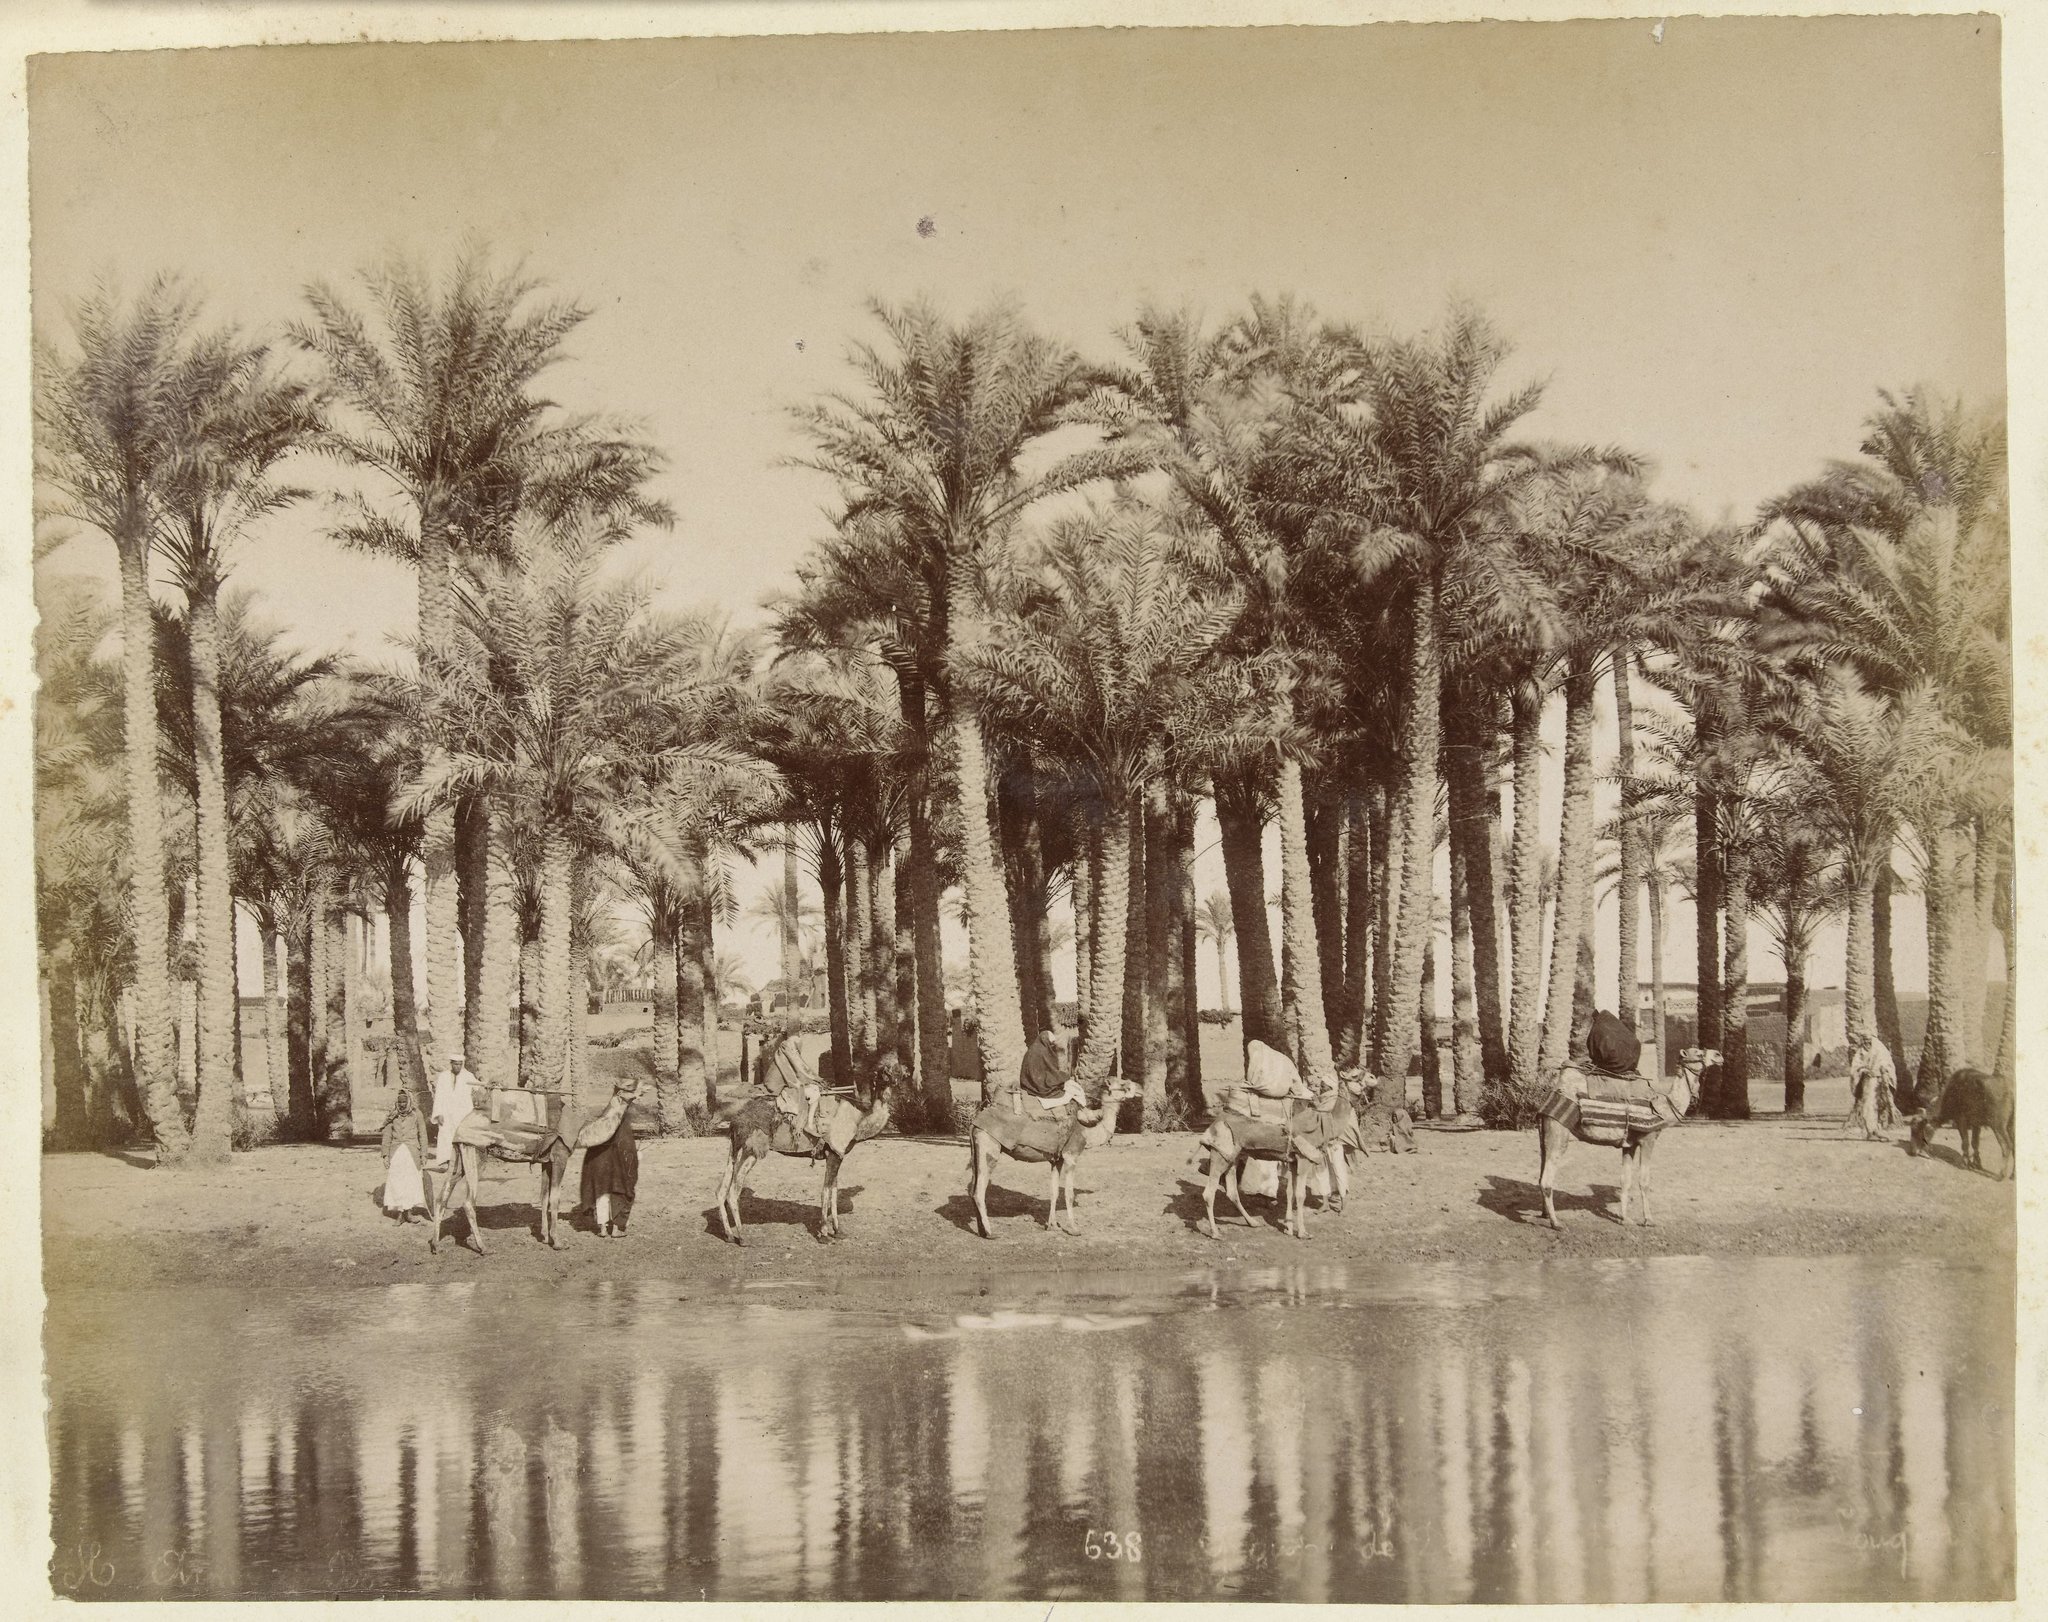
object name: photograph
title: Karavaan met bepakte drommedarissen langs een palmentuin bij een water.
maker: Anonymous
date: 1890-1910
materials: cardboard, paper, photographic support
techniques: gelatin silver print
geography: egypt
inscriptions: caption: ‘Karavaan, Cairo bereikende’